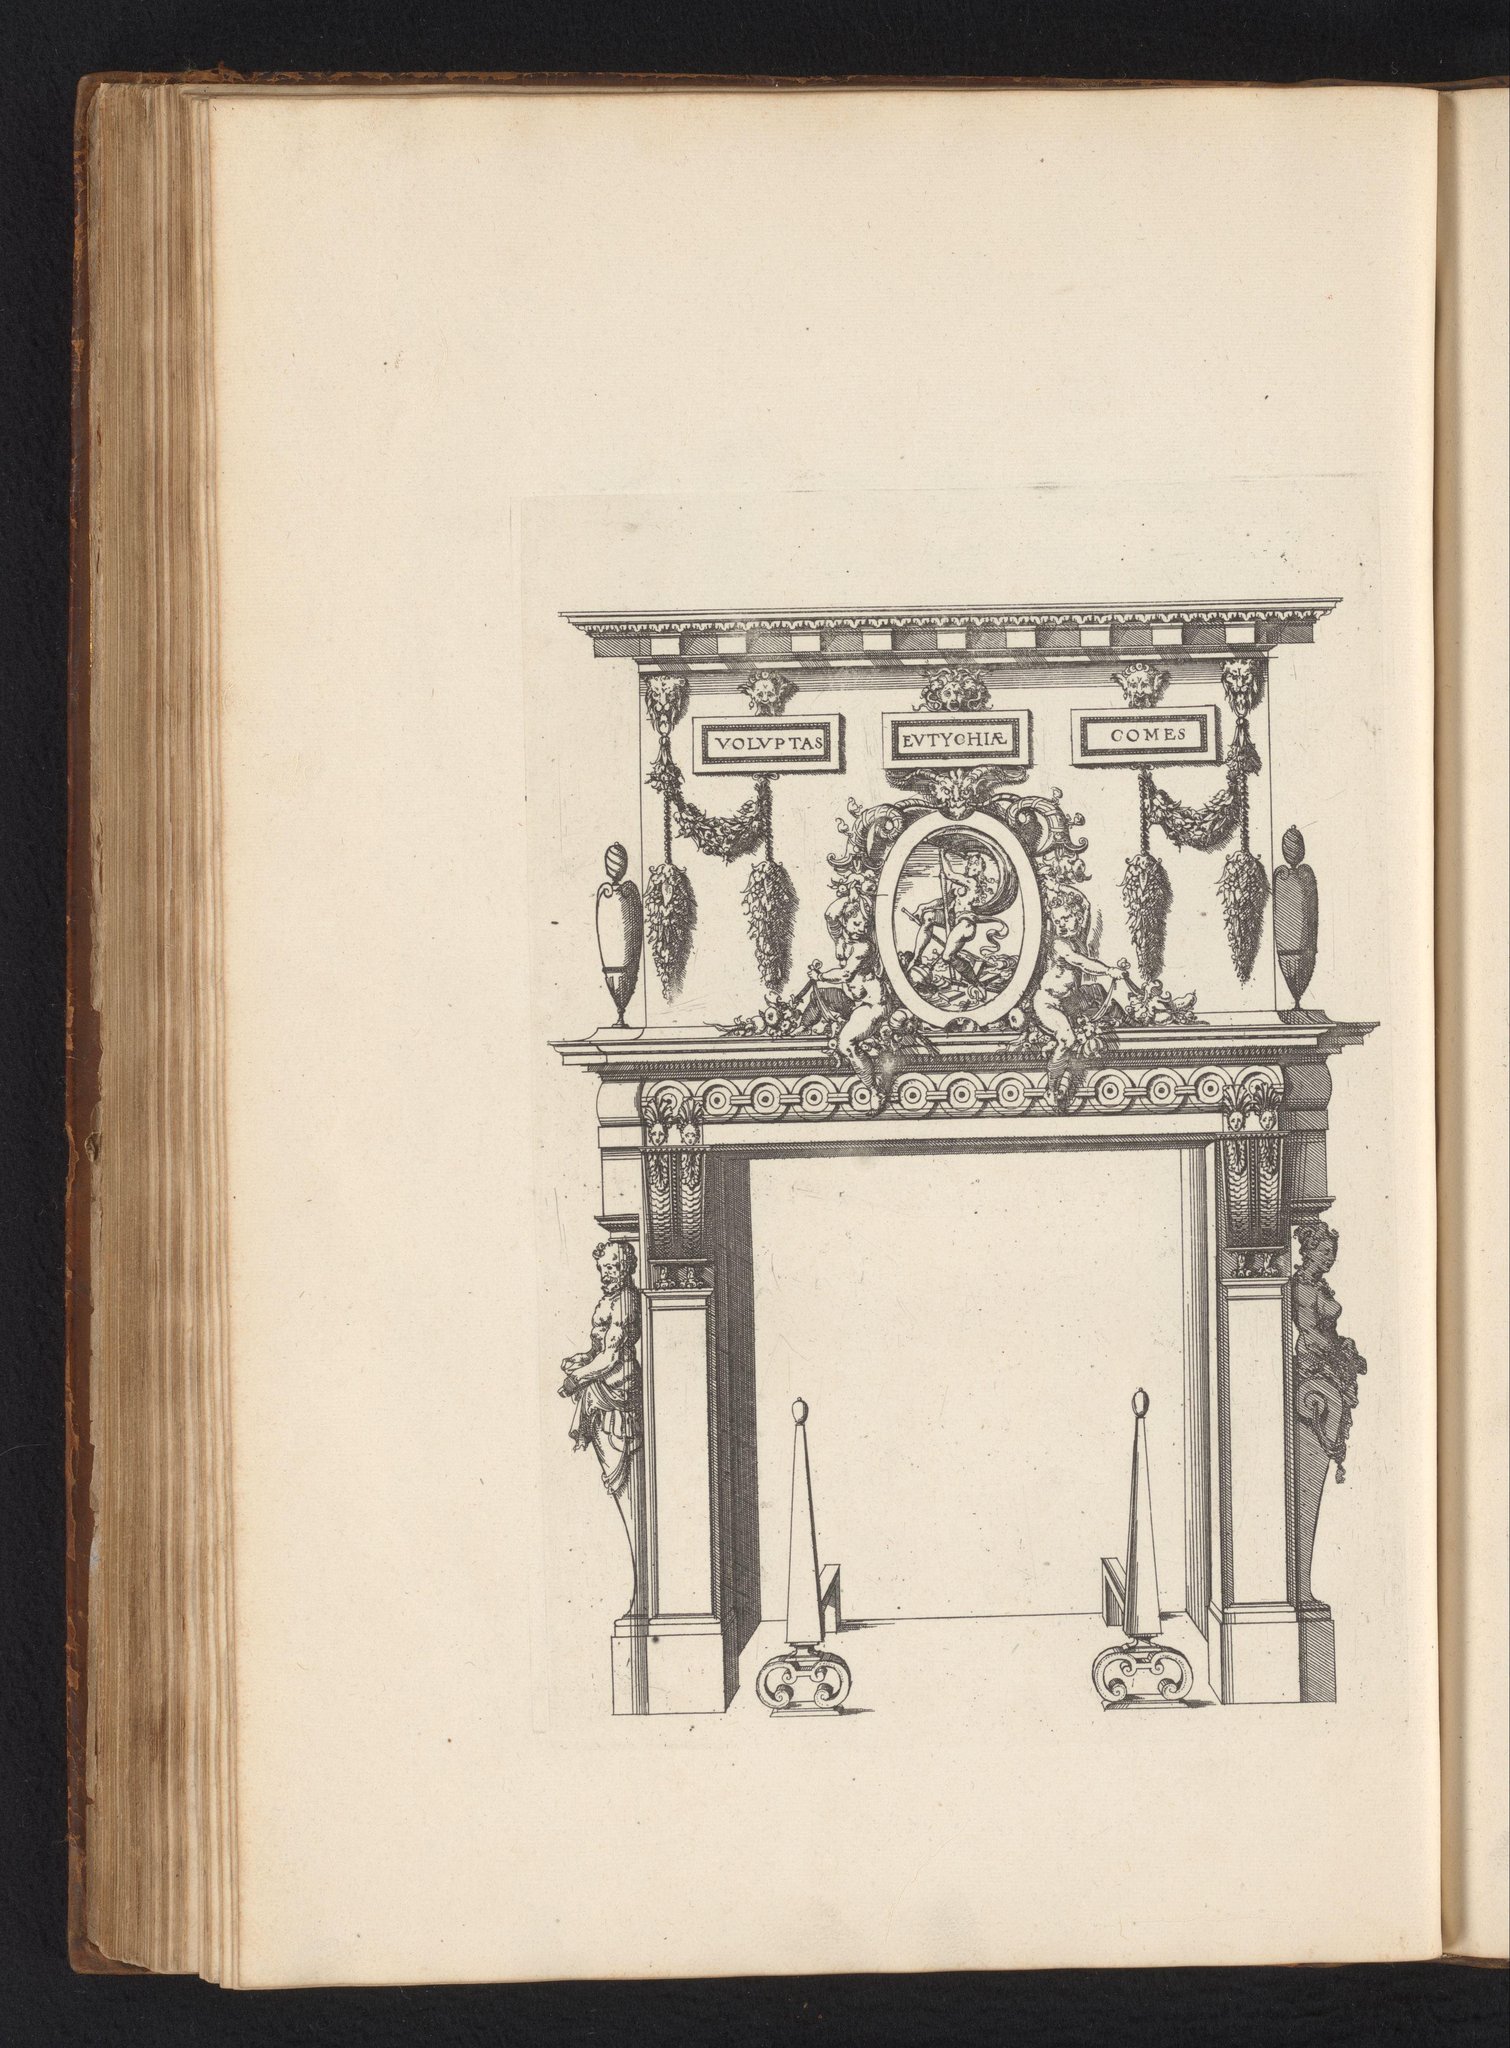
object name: ornament print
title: Schoorsteenmantel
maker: jacques androuet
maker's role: draughtsman, print maker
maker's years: 1515-1584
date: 1561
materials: paper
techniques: etching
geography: paris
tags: piece of sculpture, reproduction of a piece of sculpture, luck, fortune, lot; 'fato', 'fortuna', 'fortuna aurea', 'fortuna buona', 'fortuna pacifica overo clemente', 'sorte' (ripa), architectural design or model, chimney-piece, mantelpiece, paddle-wheel boat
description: Schoorsteenmantel met aan weerszijden hermen en op de schouw een ovaal medaillon met Fortuna met een zeil gezeten op een vaartuig met schoeprad. Onderdeel van 'Seconde livre d'architectvre' (1561): 64 etsen met geornamenteerde architectuuronderdelen.